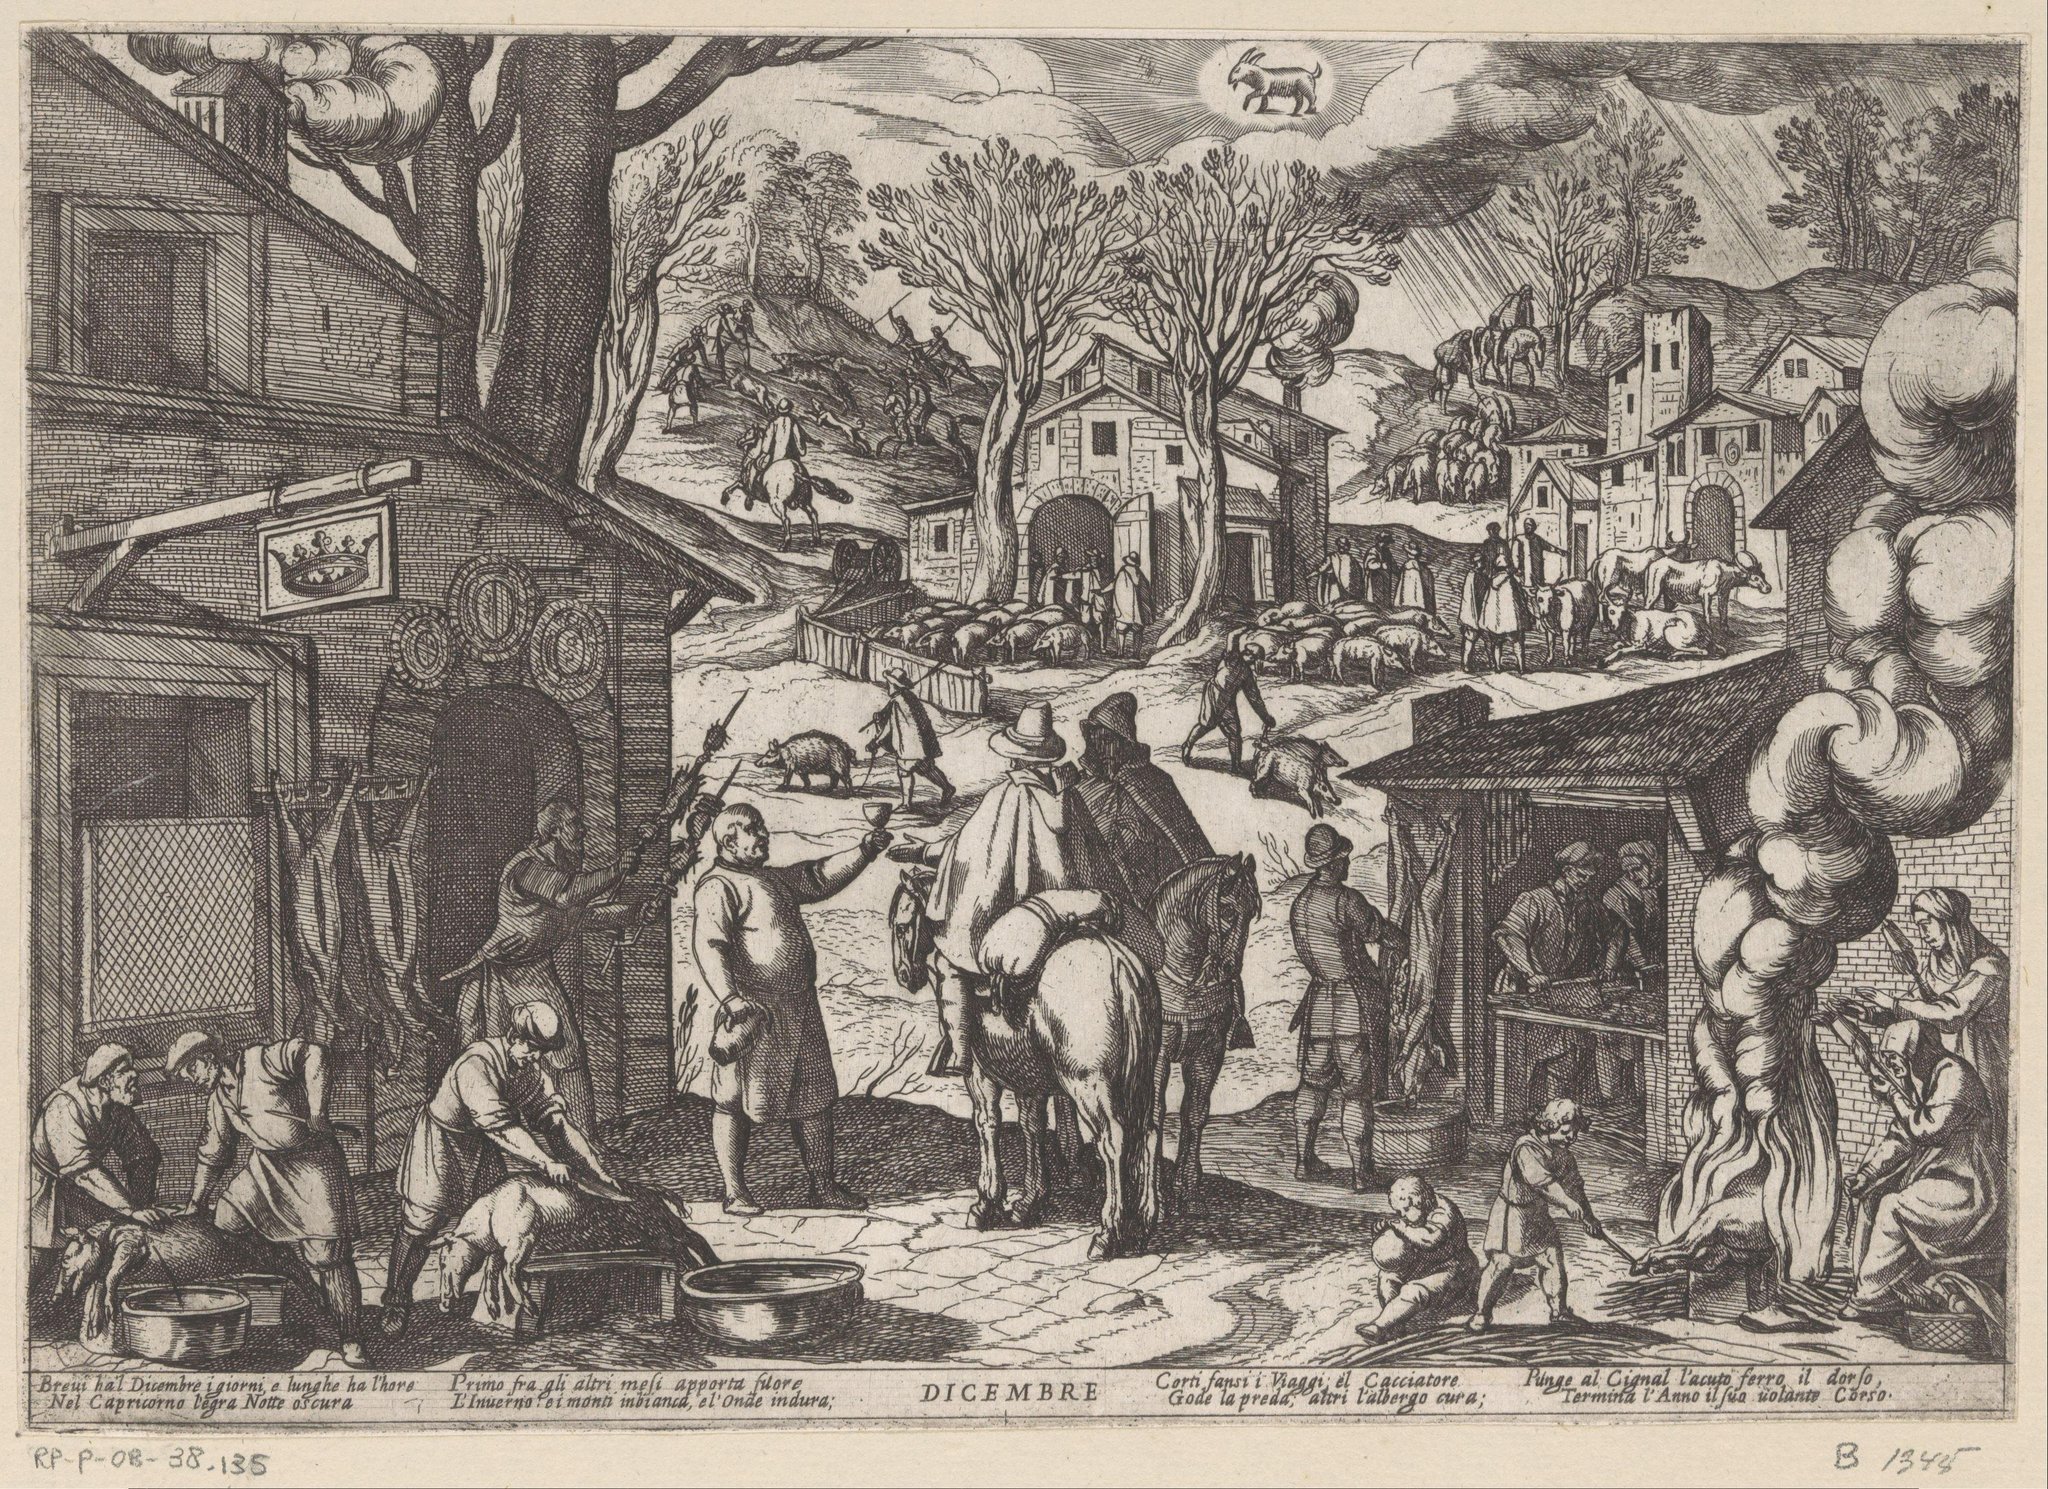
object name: print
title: De twaalf maanden (deel 1)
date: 1599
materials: paper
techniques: etching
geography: italy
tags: the twelve months represented by scenes showing human activities, usually in a landscape; so-called 'labours of the months', butcher, slaughterman, capricorn (zodiacal sign of december), hotel, hostelry, inn, village square, place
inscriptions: collector's mark: Lugt 240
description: Verbeelding van menselijke activiteit in de maand december. Gezicht op een dorpsplein met slagers, een herberg en een veemarkt. Midden boven het symbool voor het sterrenbeeld steenbok. Italiaans vers en titel in ondermarge.